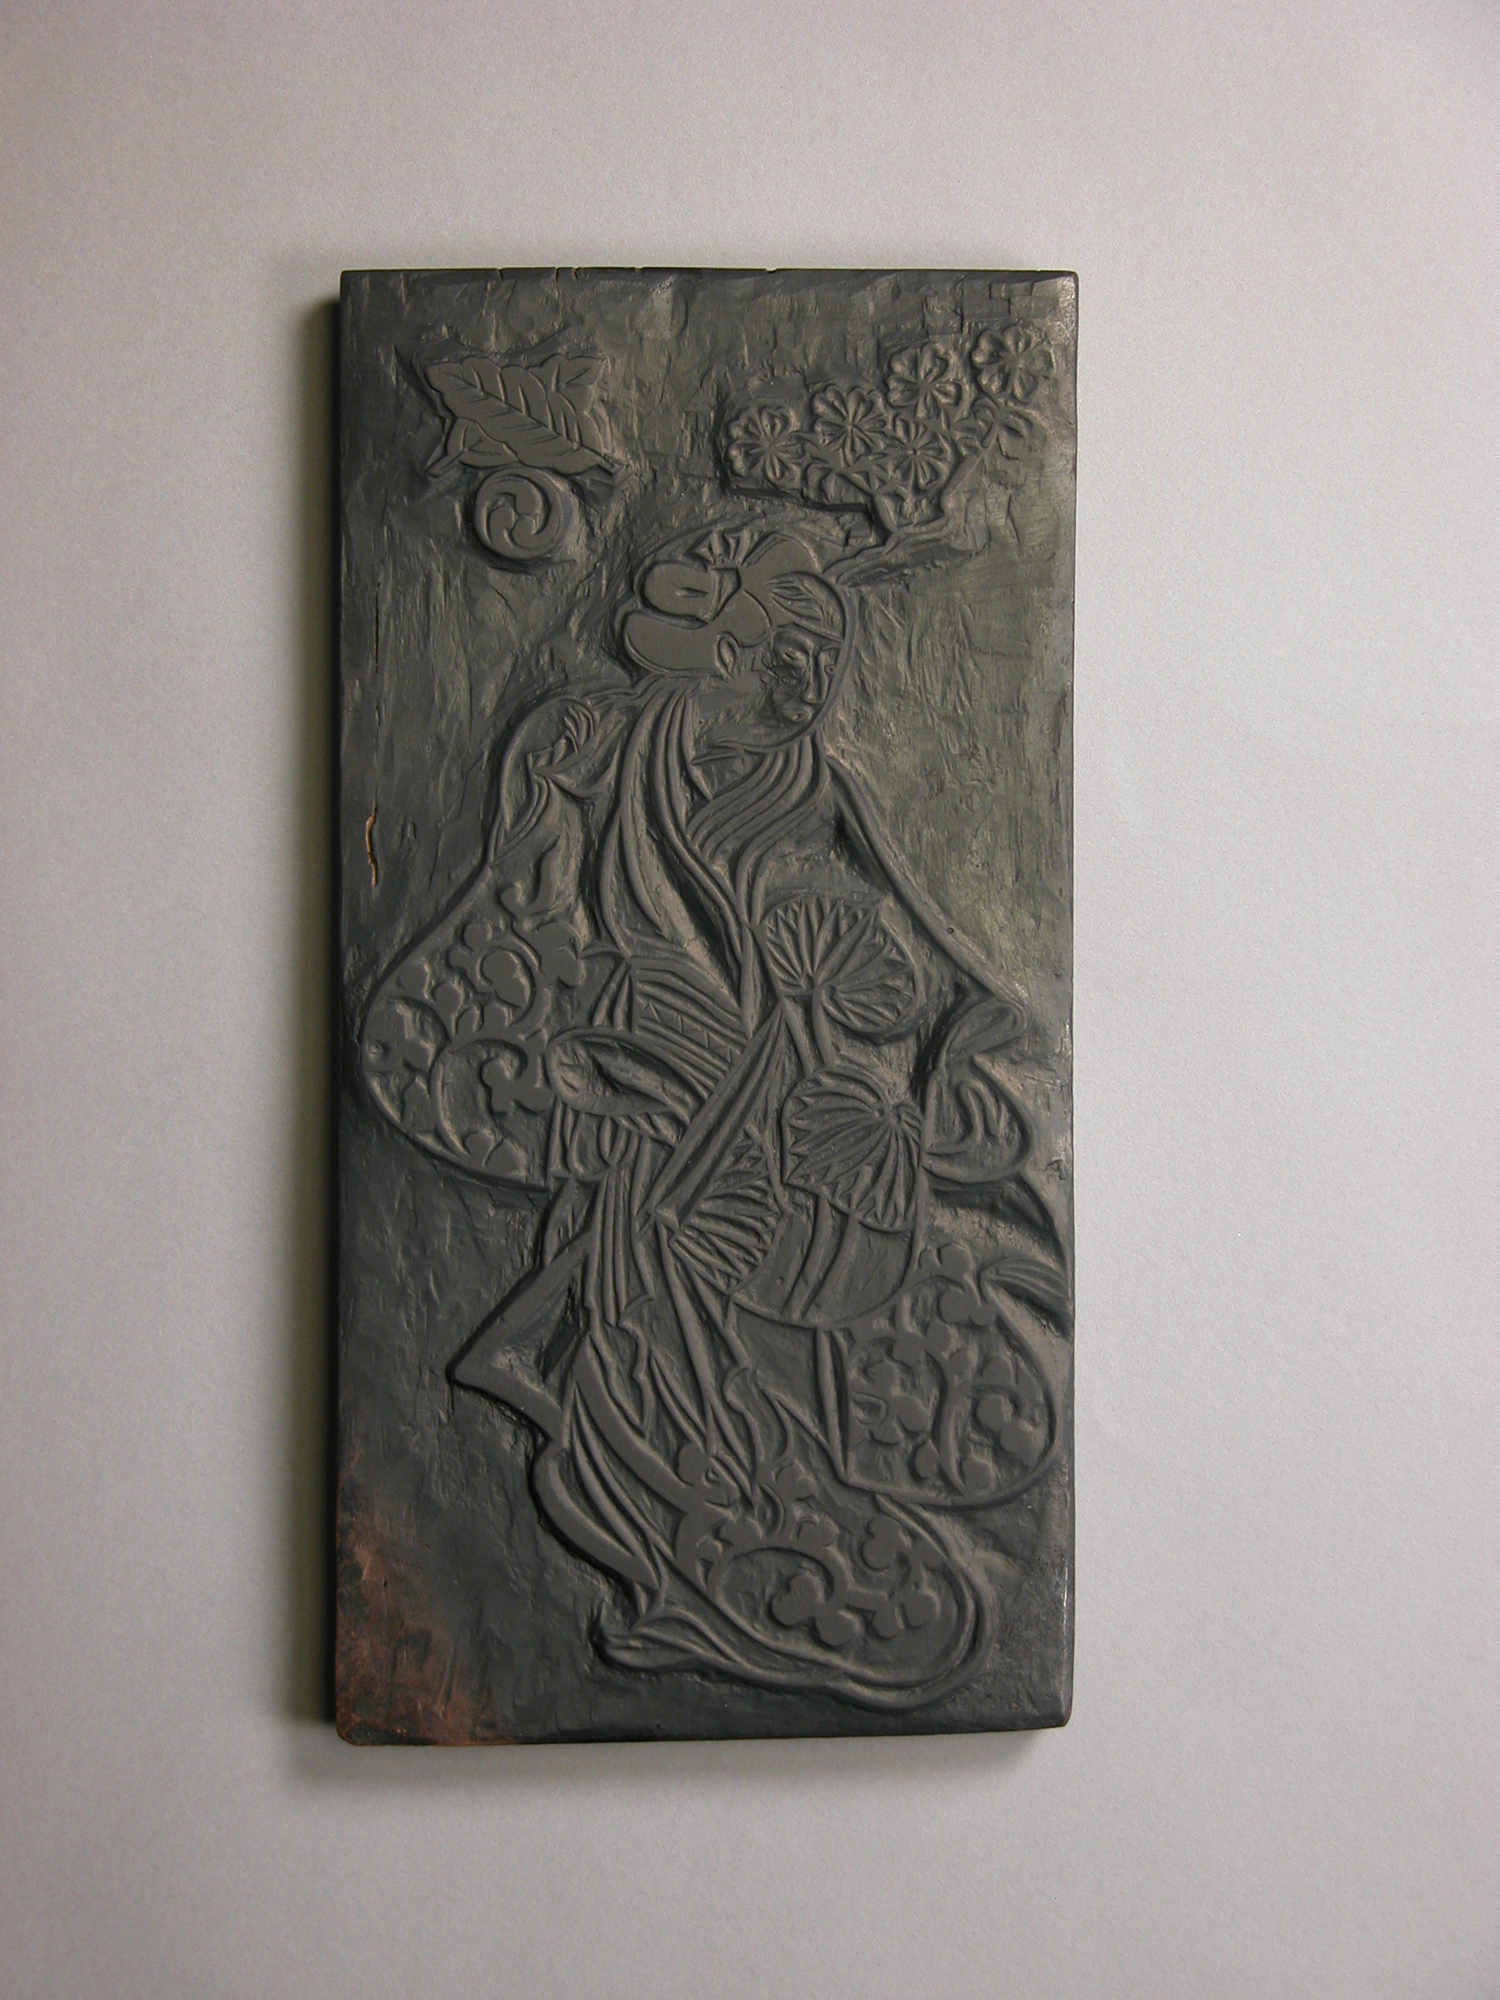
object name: printer's woodblock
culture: japanese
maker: unidentified artist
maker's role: artist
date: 1730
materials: wood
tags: flowers